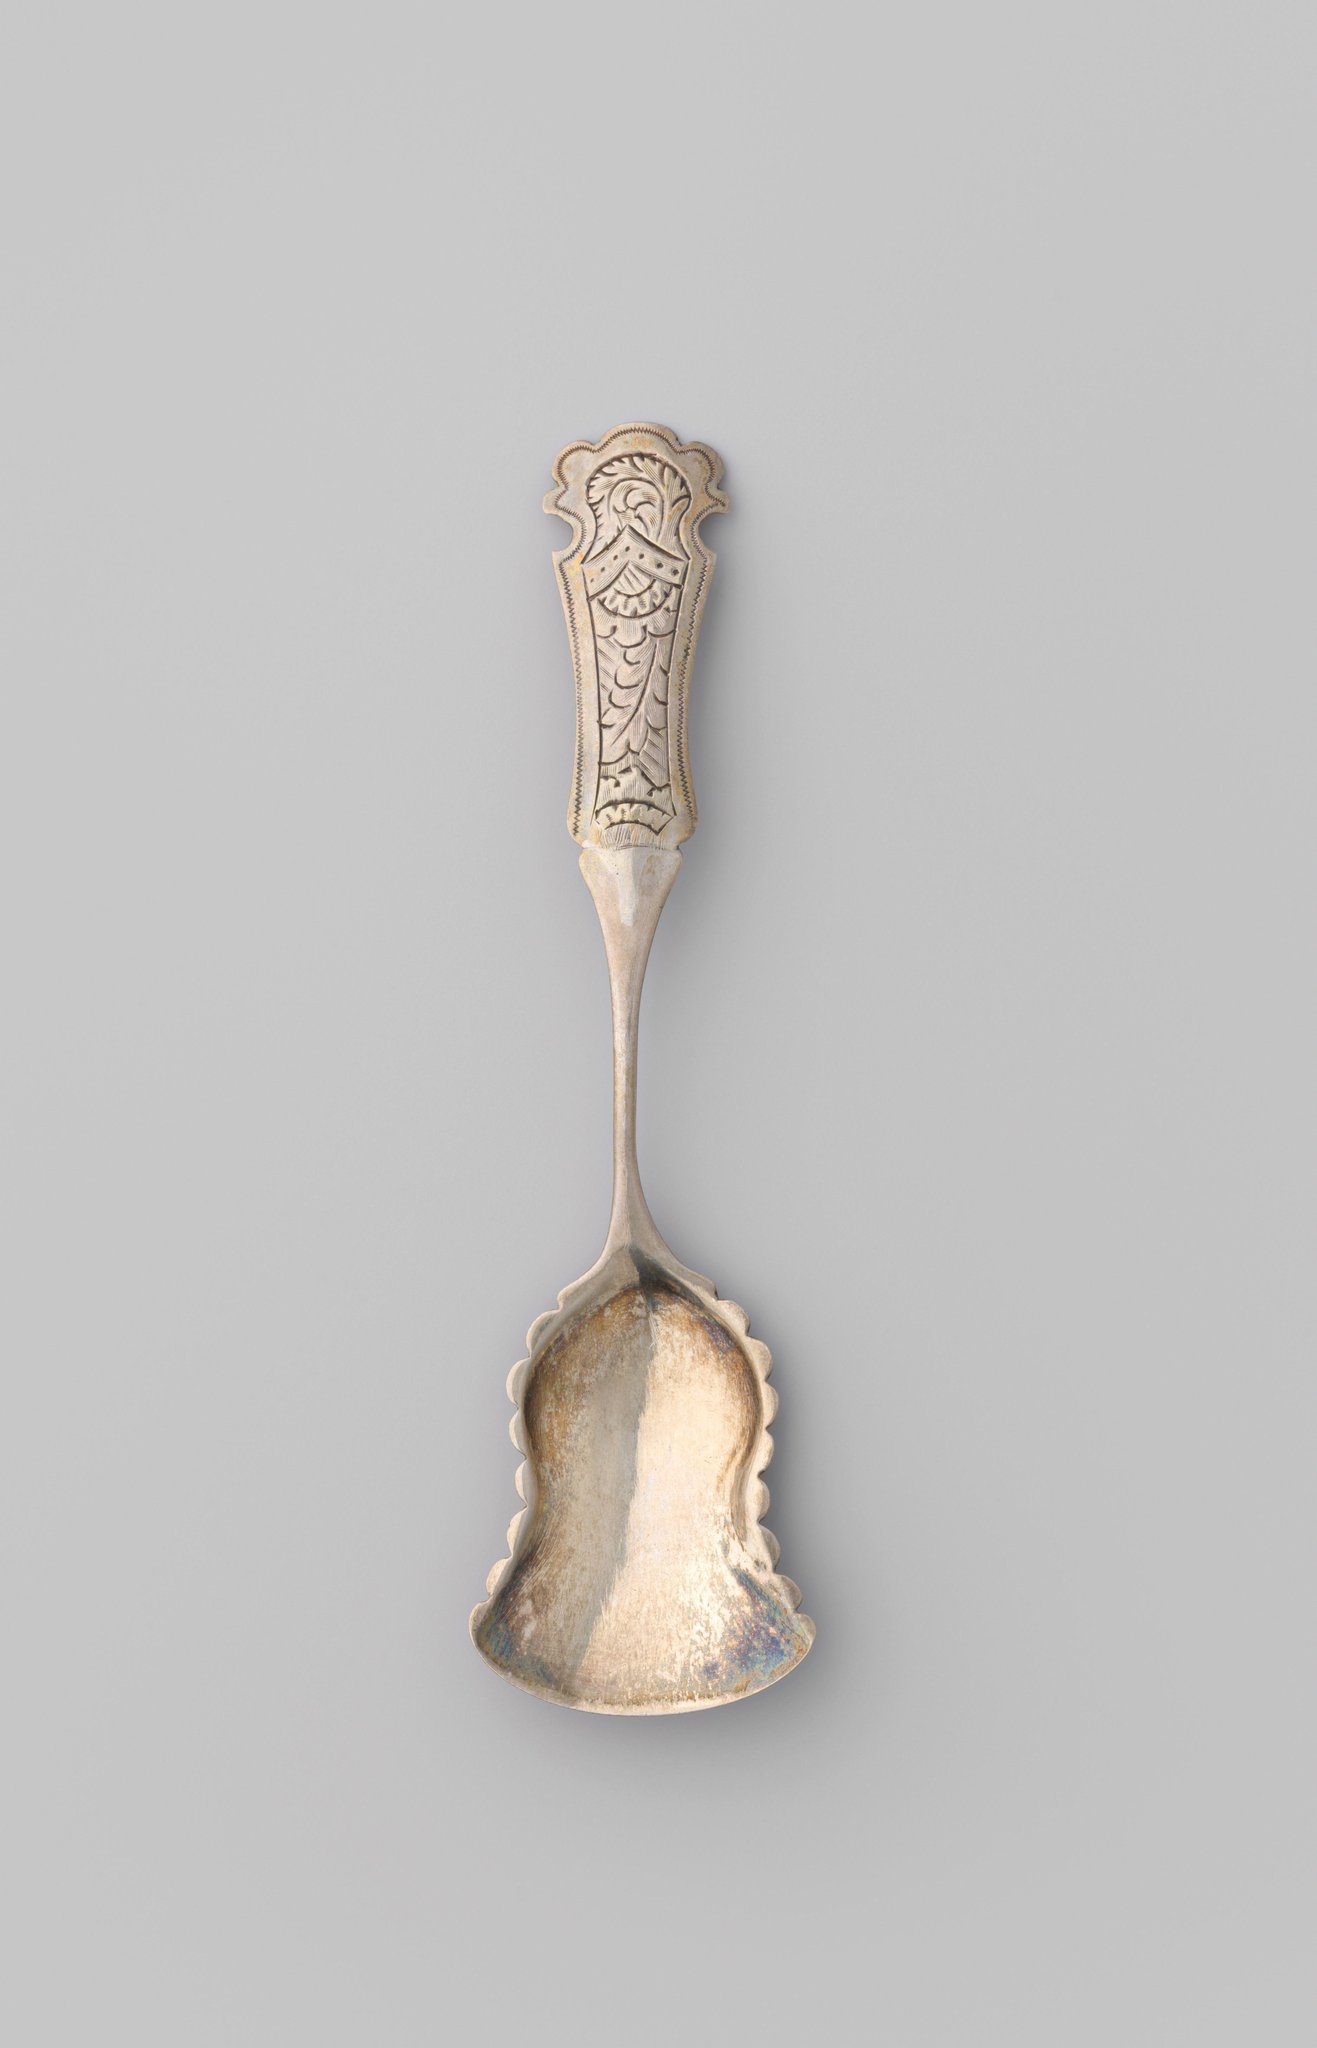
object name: teaspoon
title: Theelepel van zilver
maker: antonius hendrikus der kinderen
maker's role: jeweler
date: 1850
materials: silver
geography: den bosch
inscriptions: mark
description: Zilveren theelepel met een kolenschopbak, en gegraveerd met initialen FA. Merken: leeuw met 2. gehelmde kop, Q (1850), meesterteken: onder elkaar DK-44.